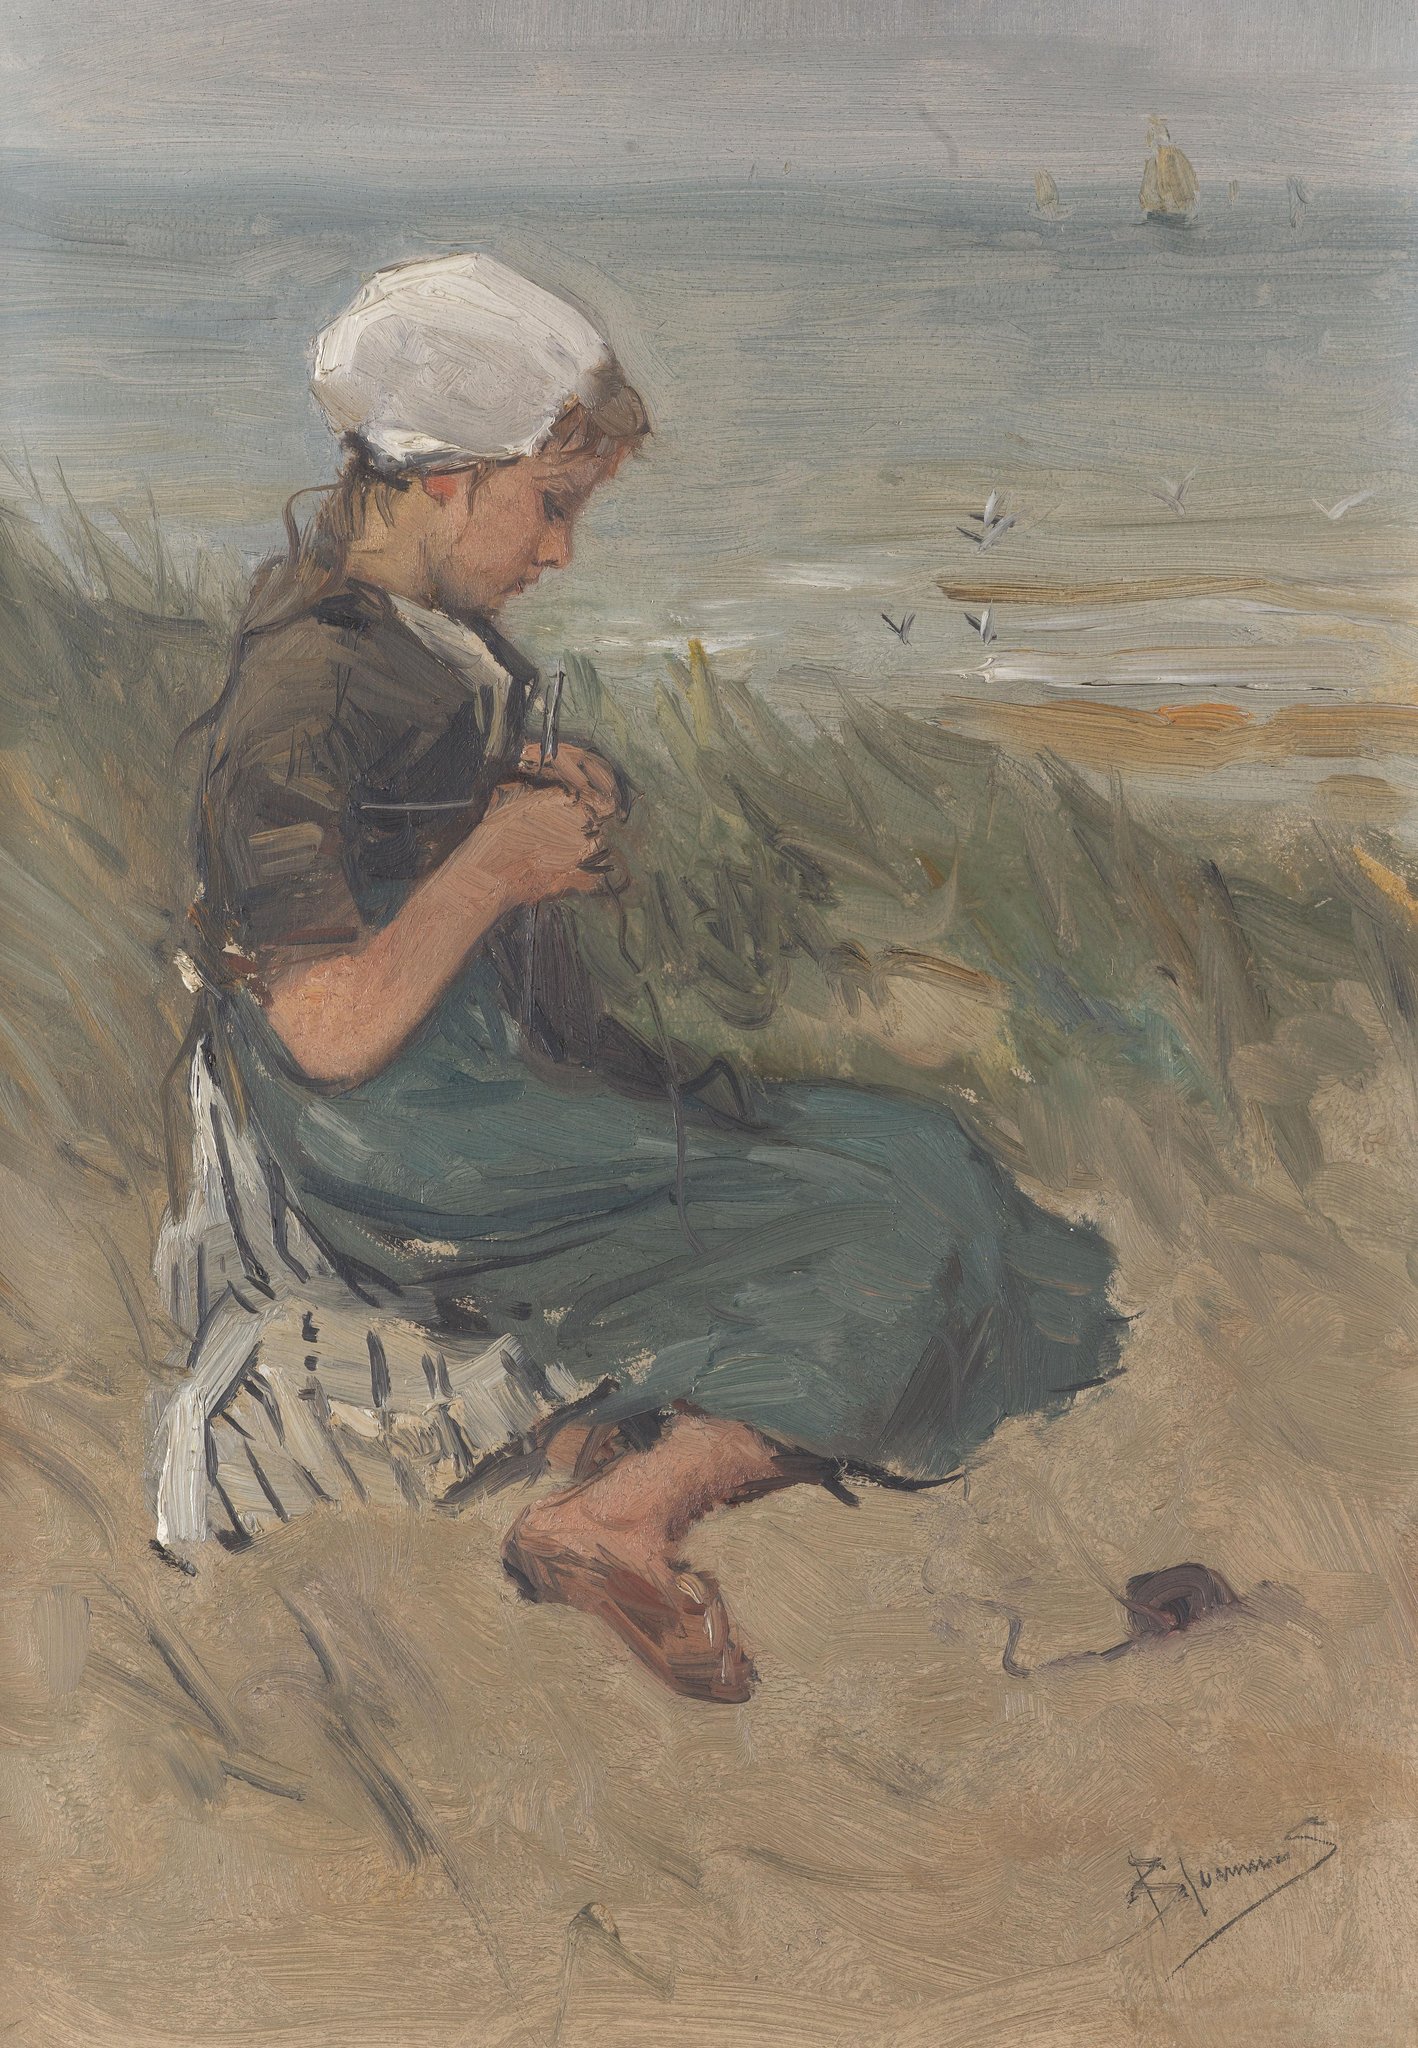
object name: painting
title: Girl Knitting in the Dunes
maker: bernardus johannes blommers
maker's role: draughtsman, print maker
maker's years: 1845-1914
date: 1870-1900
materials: oil, panel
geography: netherlands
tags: dune coast, knitting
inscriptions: signature: ‘Blommers’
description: Breiend meisje zittend op een duin. In de verte de zee.